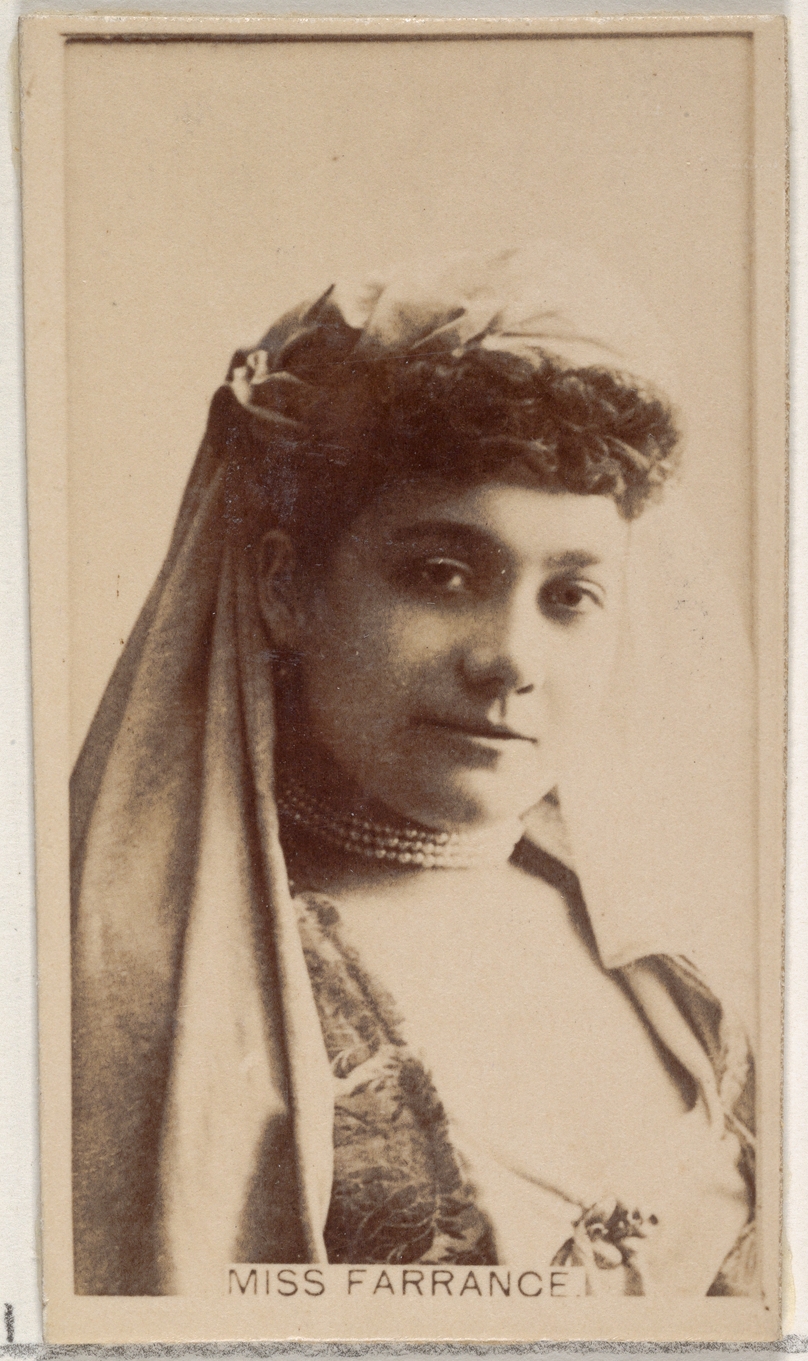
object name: photograph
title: Miss Farrance, from the Actors and Actresses series (N45, Type 8) for Virginia Brights Cigarettes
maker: allen & ginter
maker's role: publisher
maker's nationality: american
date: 1888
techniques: albumen silver print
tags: portraits,women,actresses